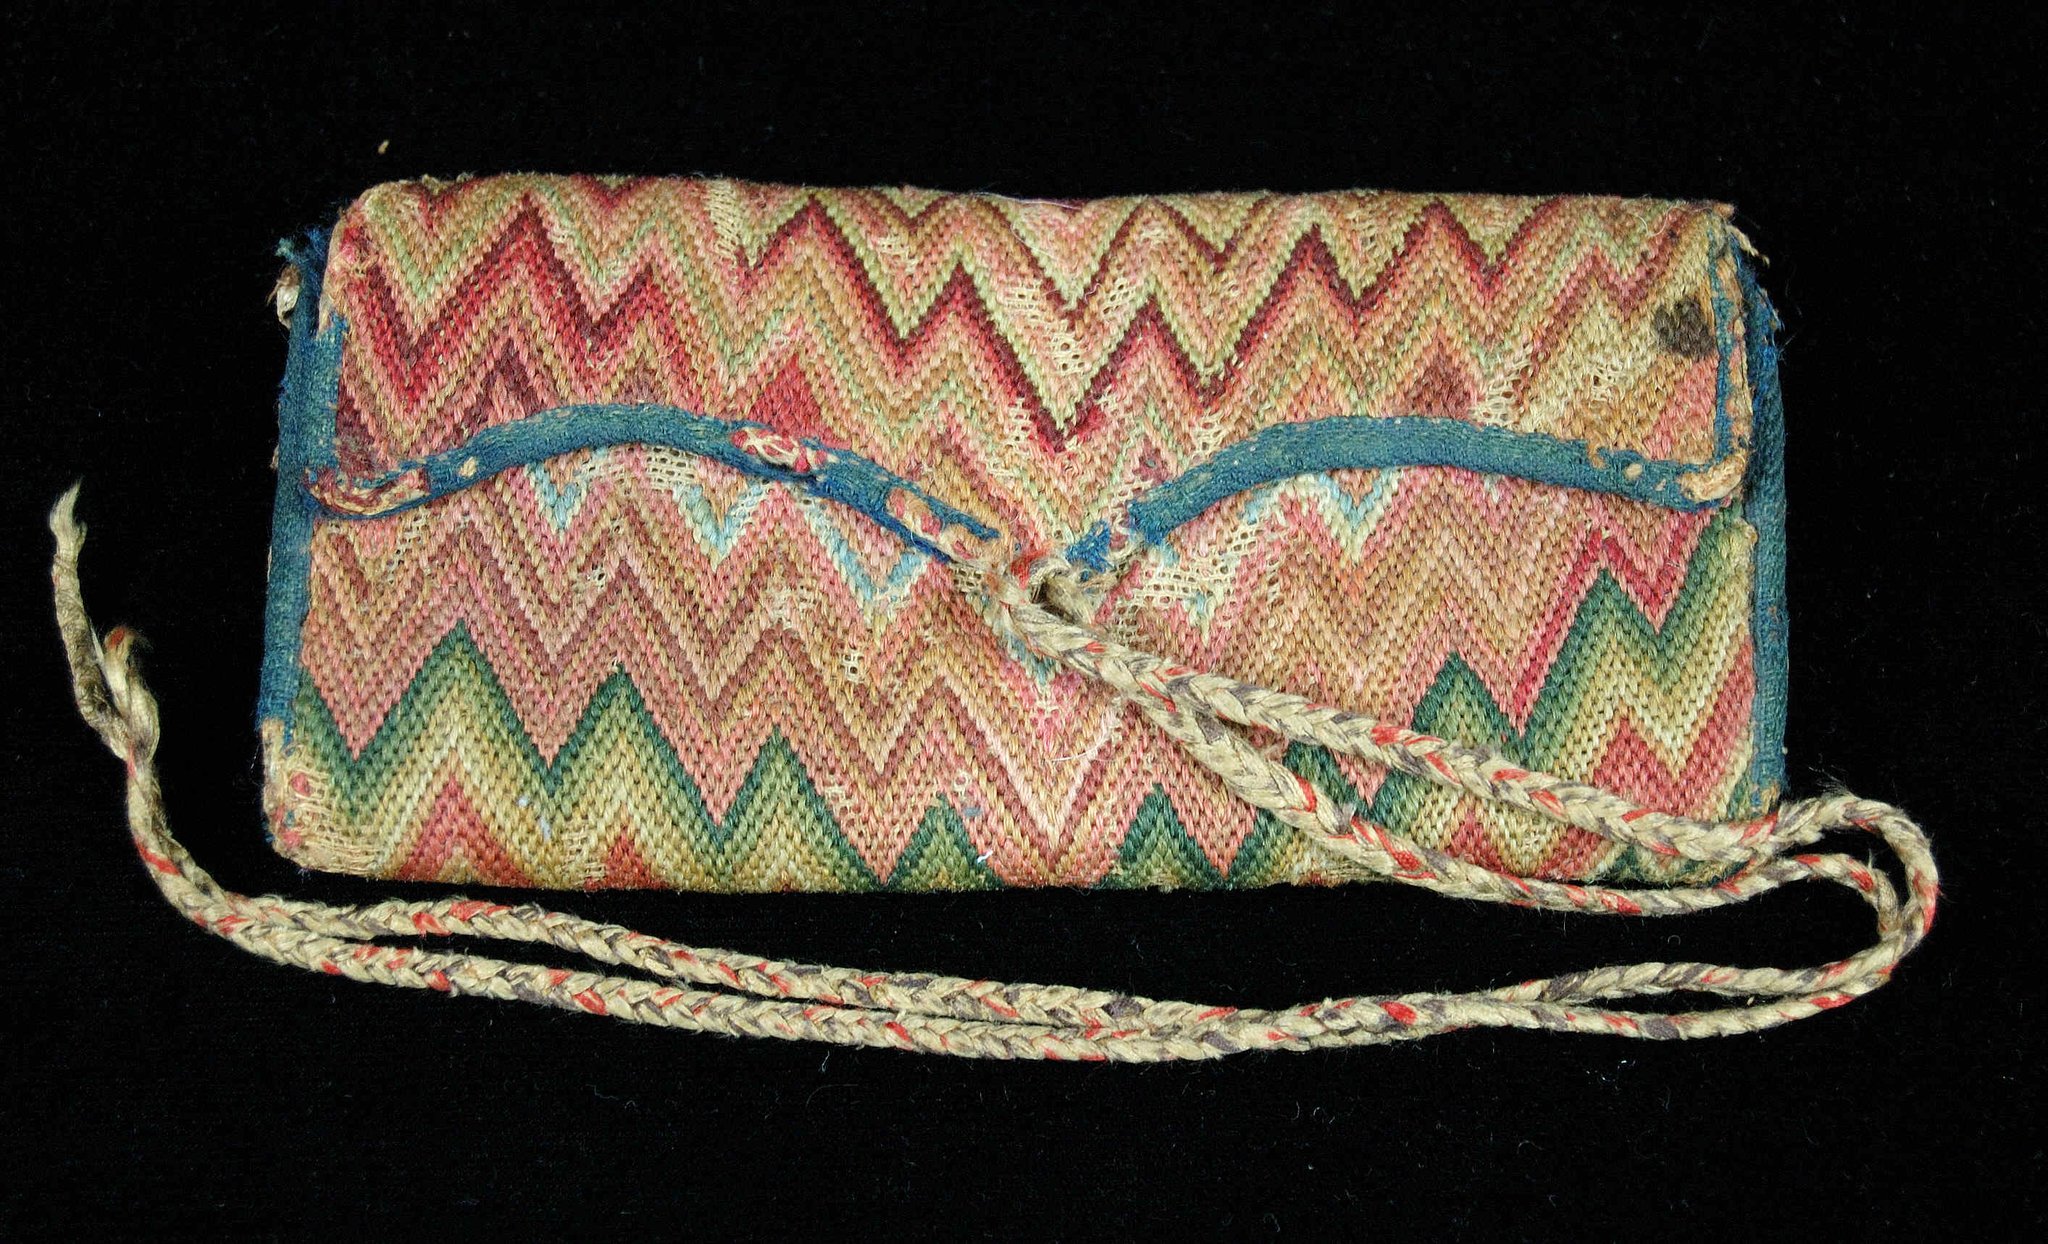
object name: bag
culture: american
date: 1775-1790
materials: cotton, wool